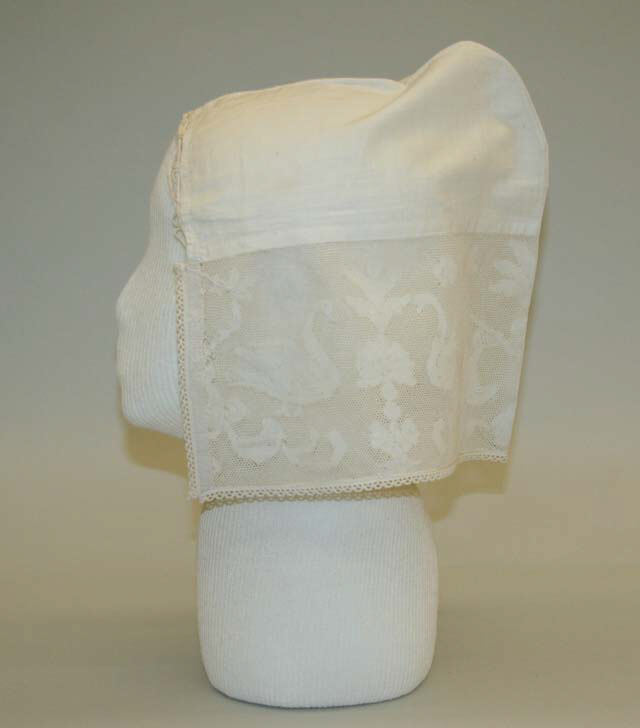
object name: cap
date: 1701-1725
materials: linen